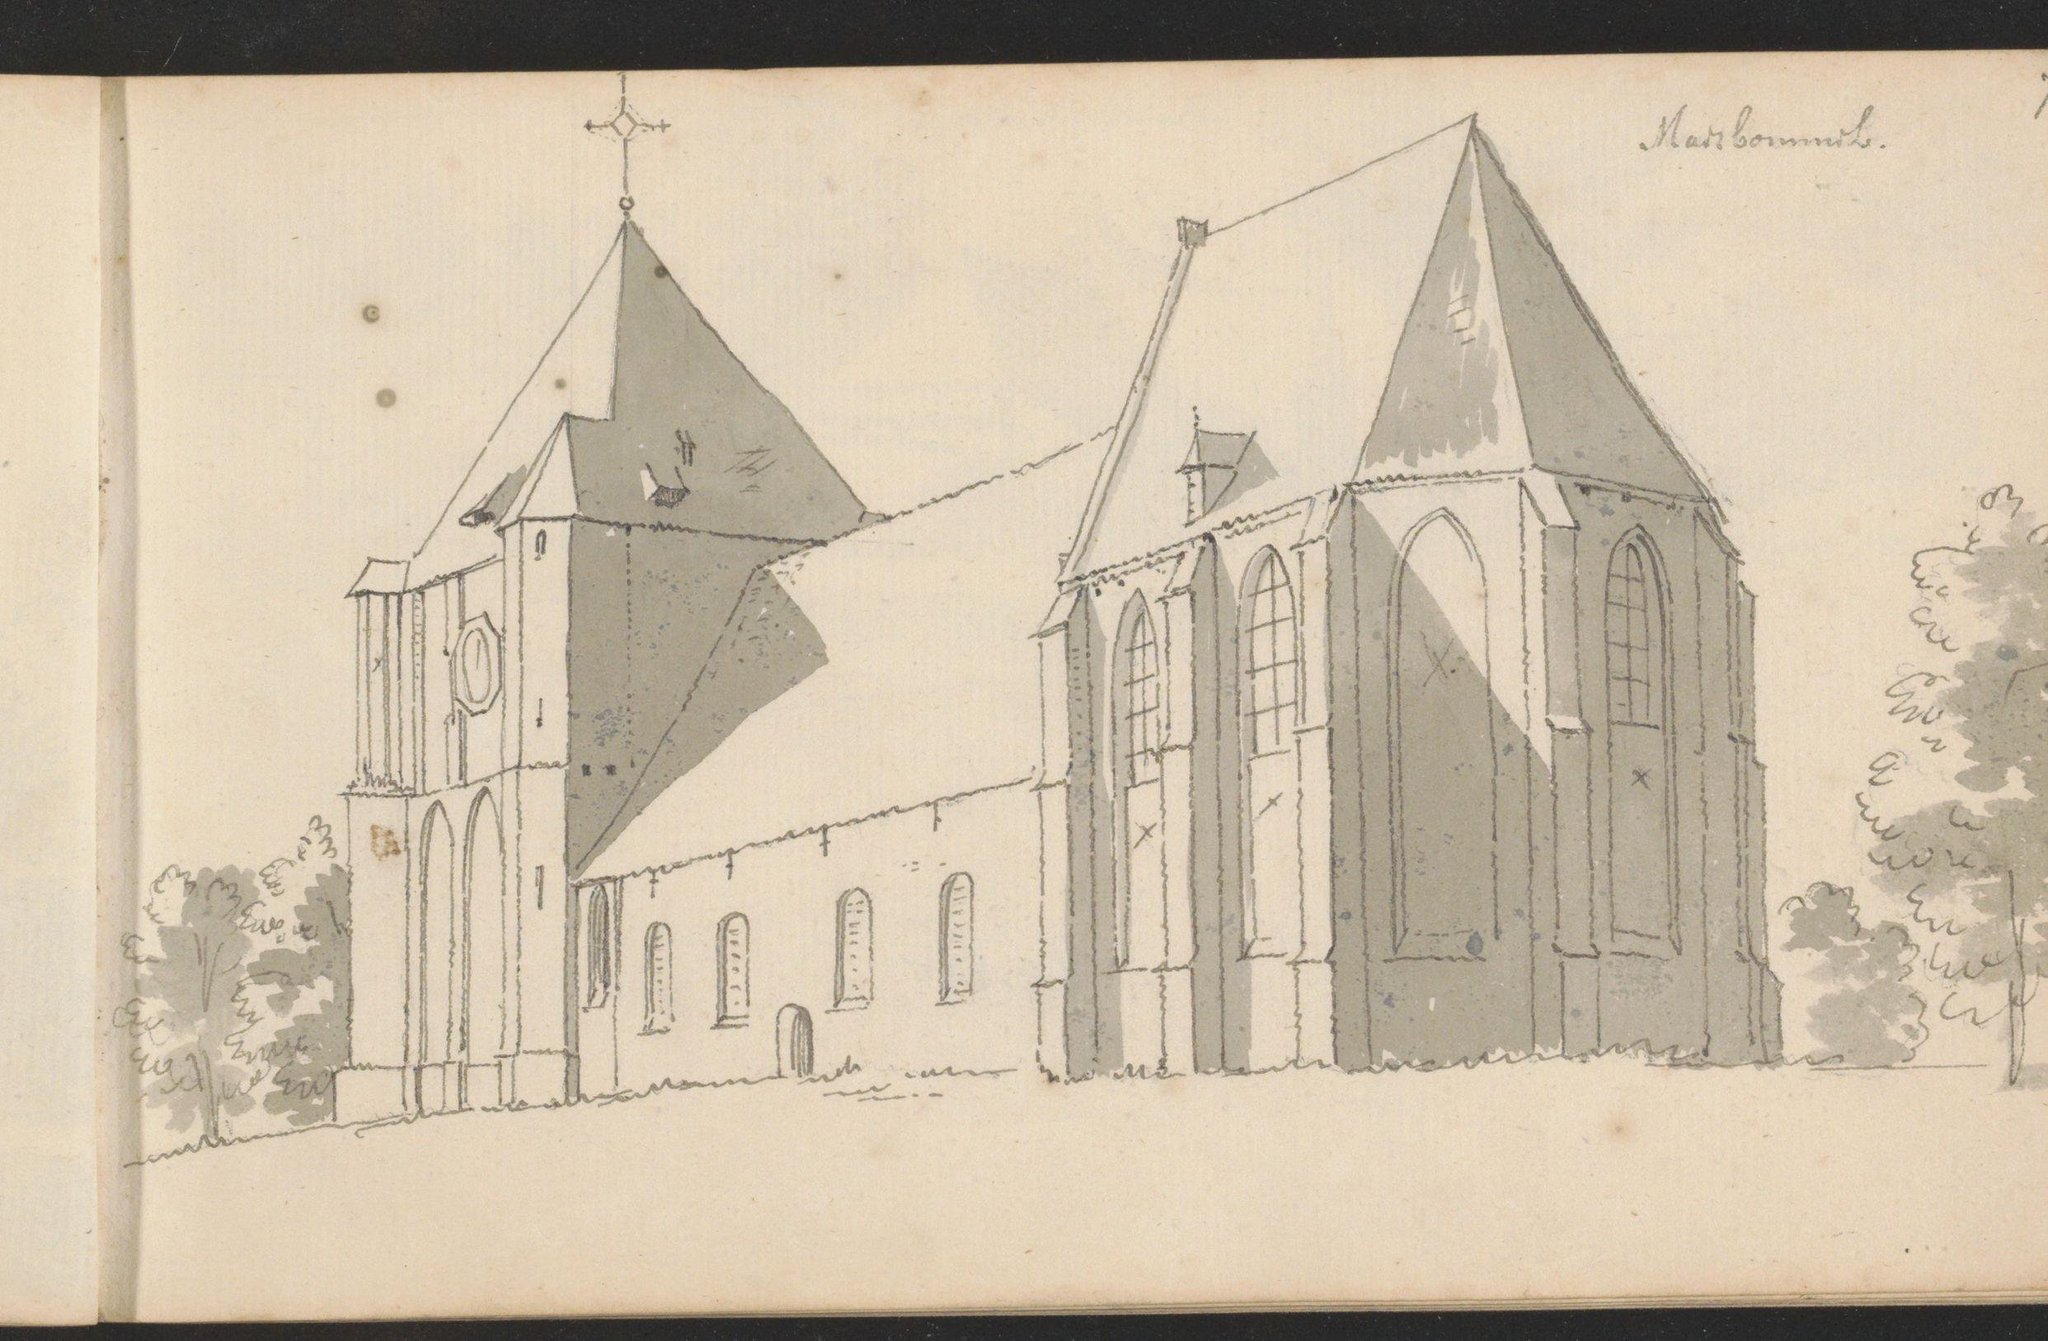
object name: sketchbook leaf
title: Kerk van Maasbommel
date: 1701-1759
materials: ink, paper, pencil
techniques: brush, pen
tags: church (exterior)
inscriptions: annotation: ‘Maasbommel’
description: Blad 7 recto uit een schetsboek met 65 bladen.